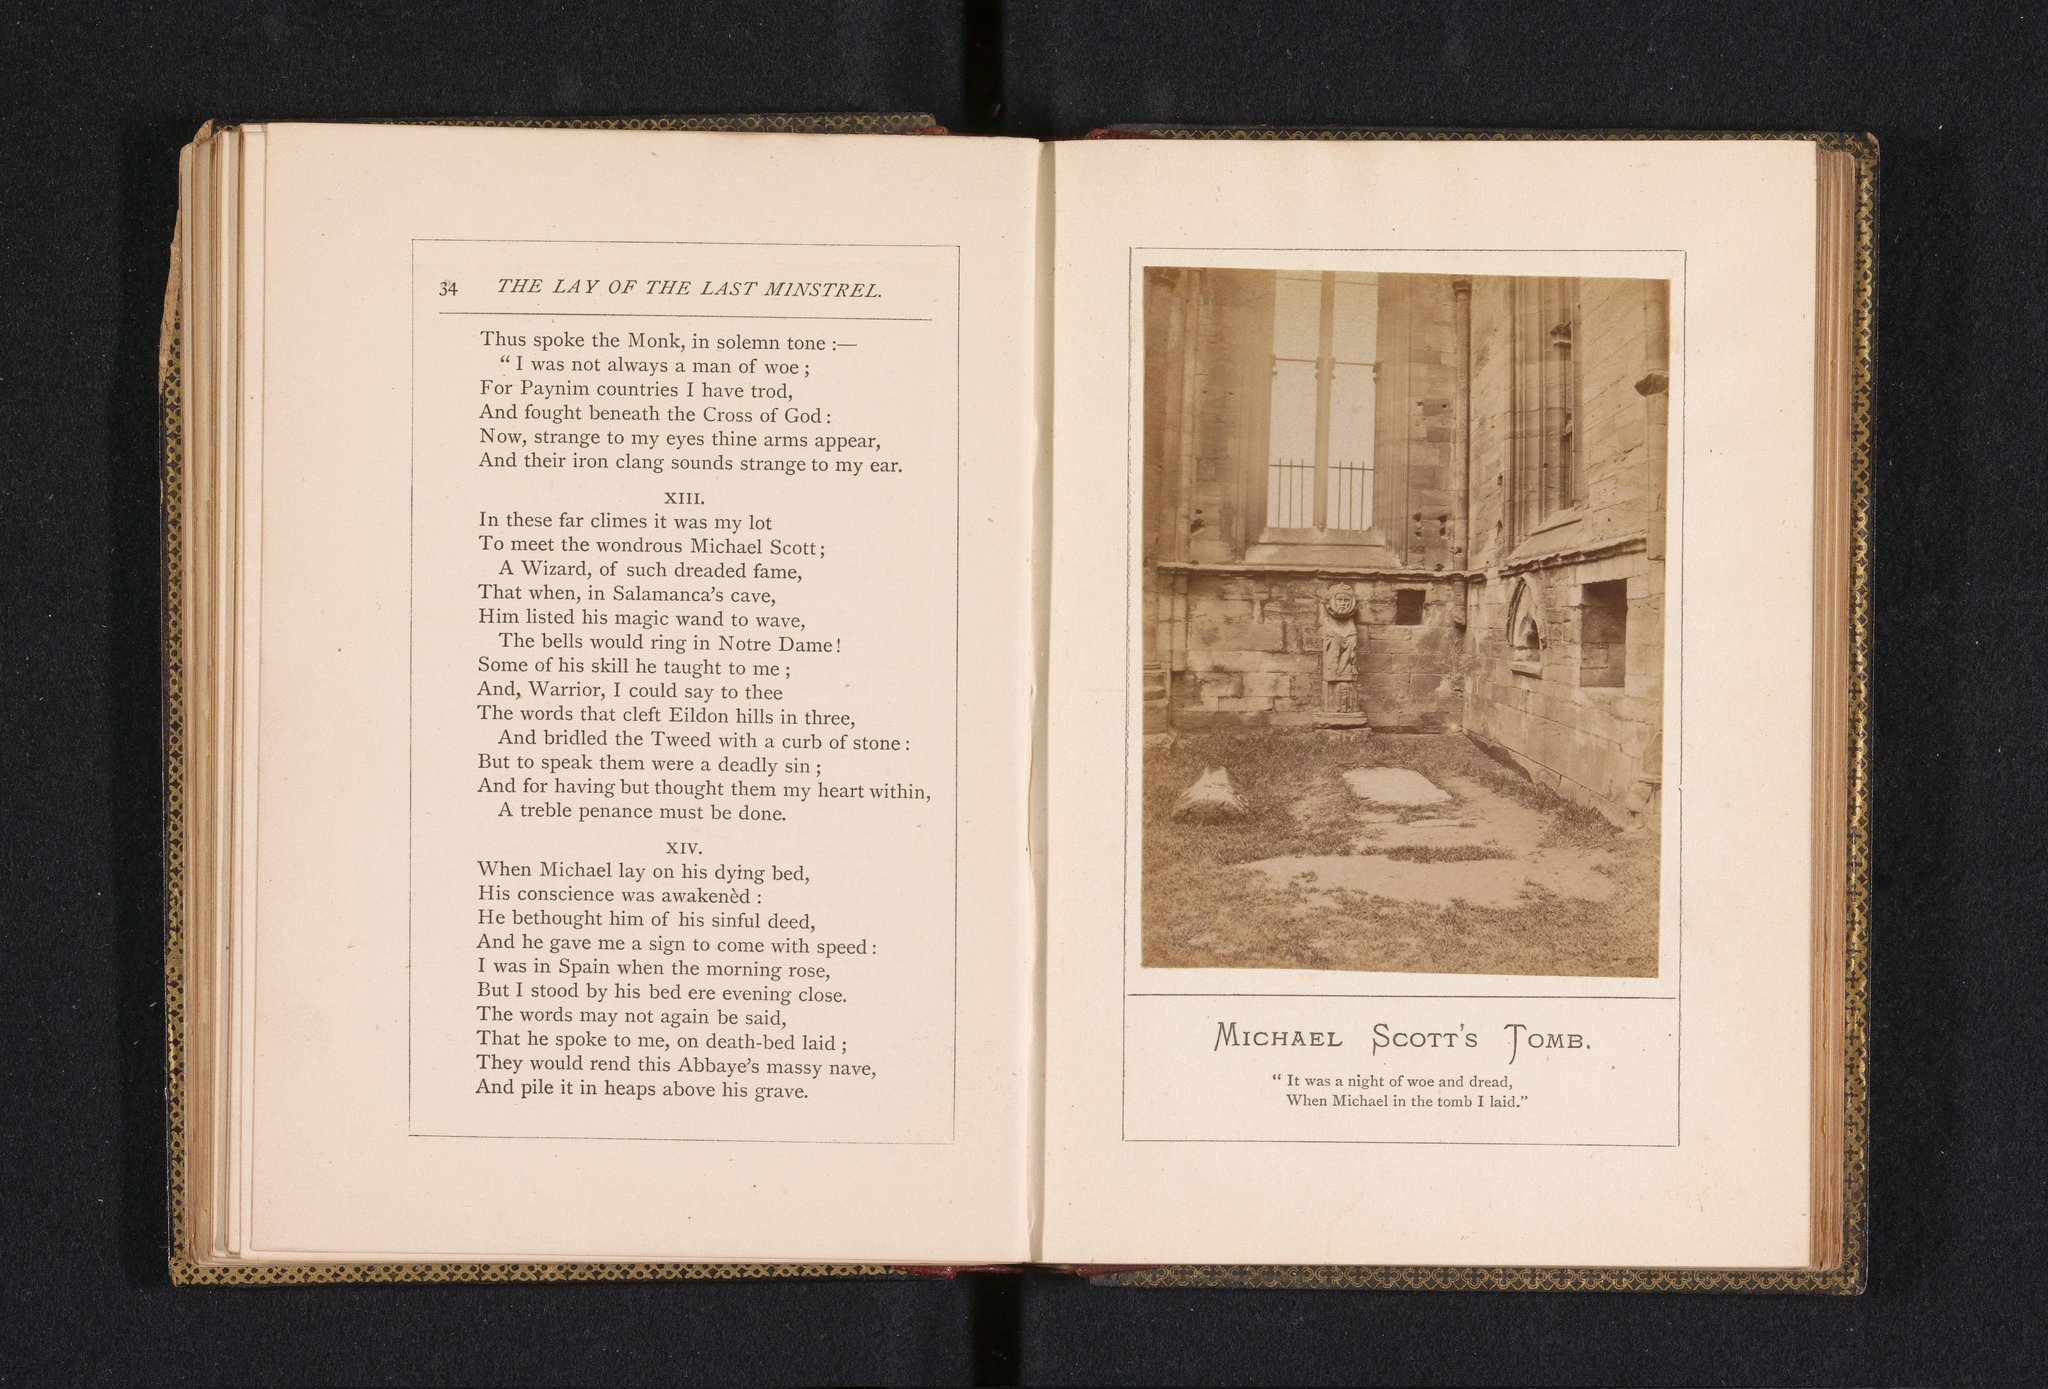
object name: page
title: Michael Scott's Tomb.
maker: Anonymous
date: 1850-1872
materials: photographic support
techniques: albumen print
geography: melrose abbey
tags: gravestone, tombstone, ruin of a dwelling, house, castle, etc.